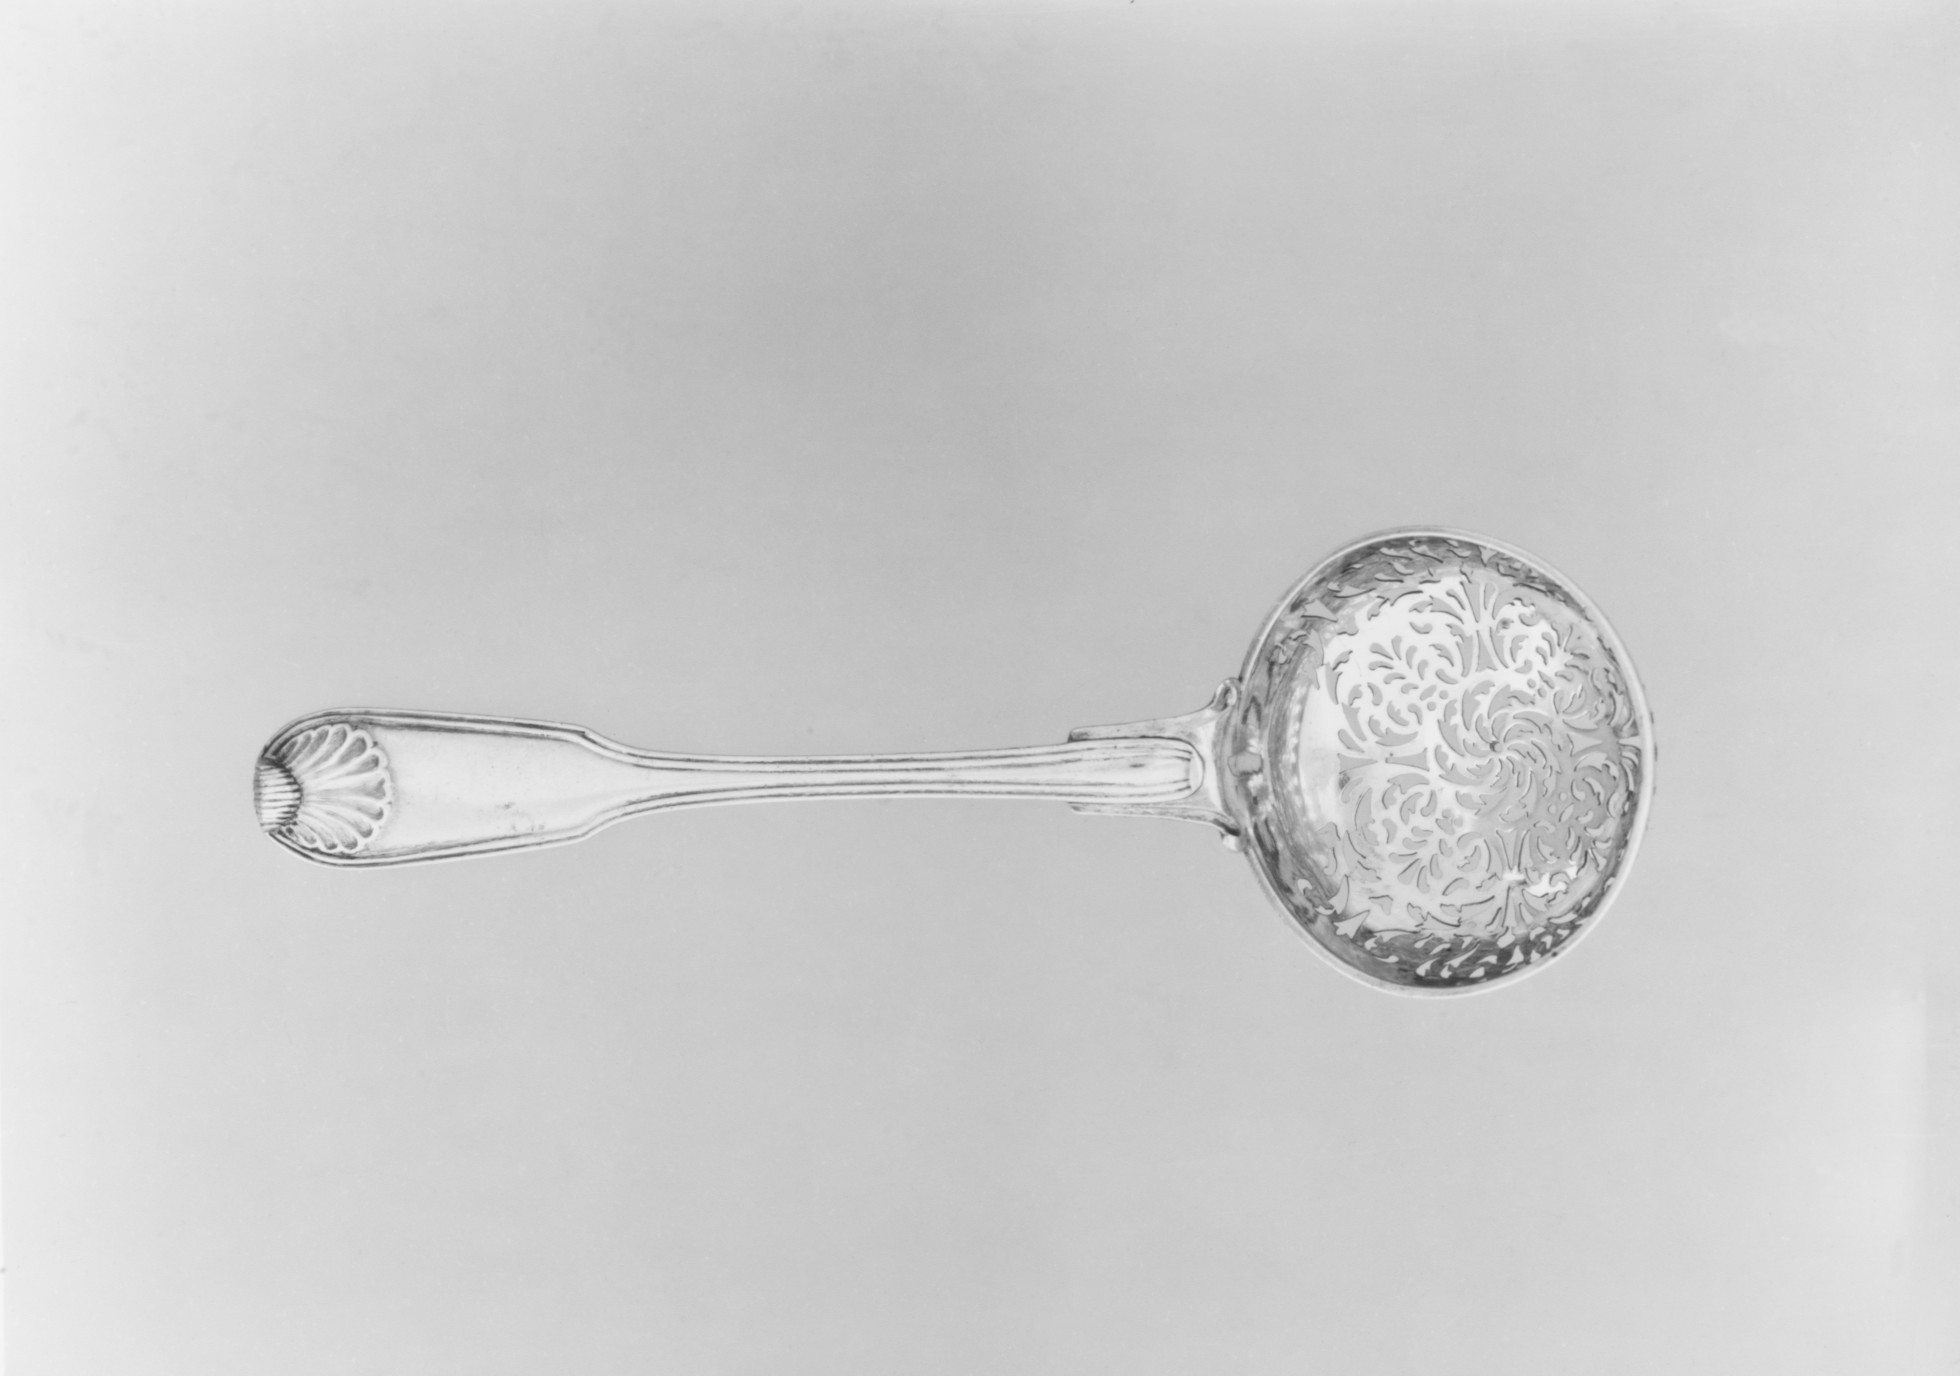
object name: sugar spoon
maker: jacques pecatier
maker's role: maker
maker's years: 1730-1790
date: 1767-1768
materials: silver